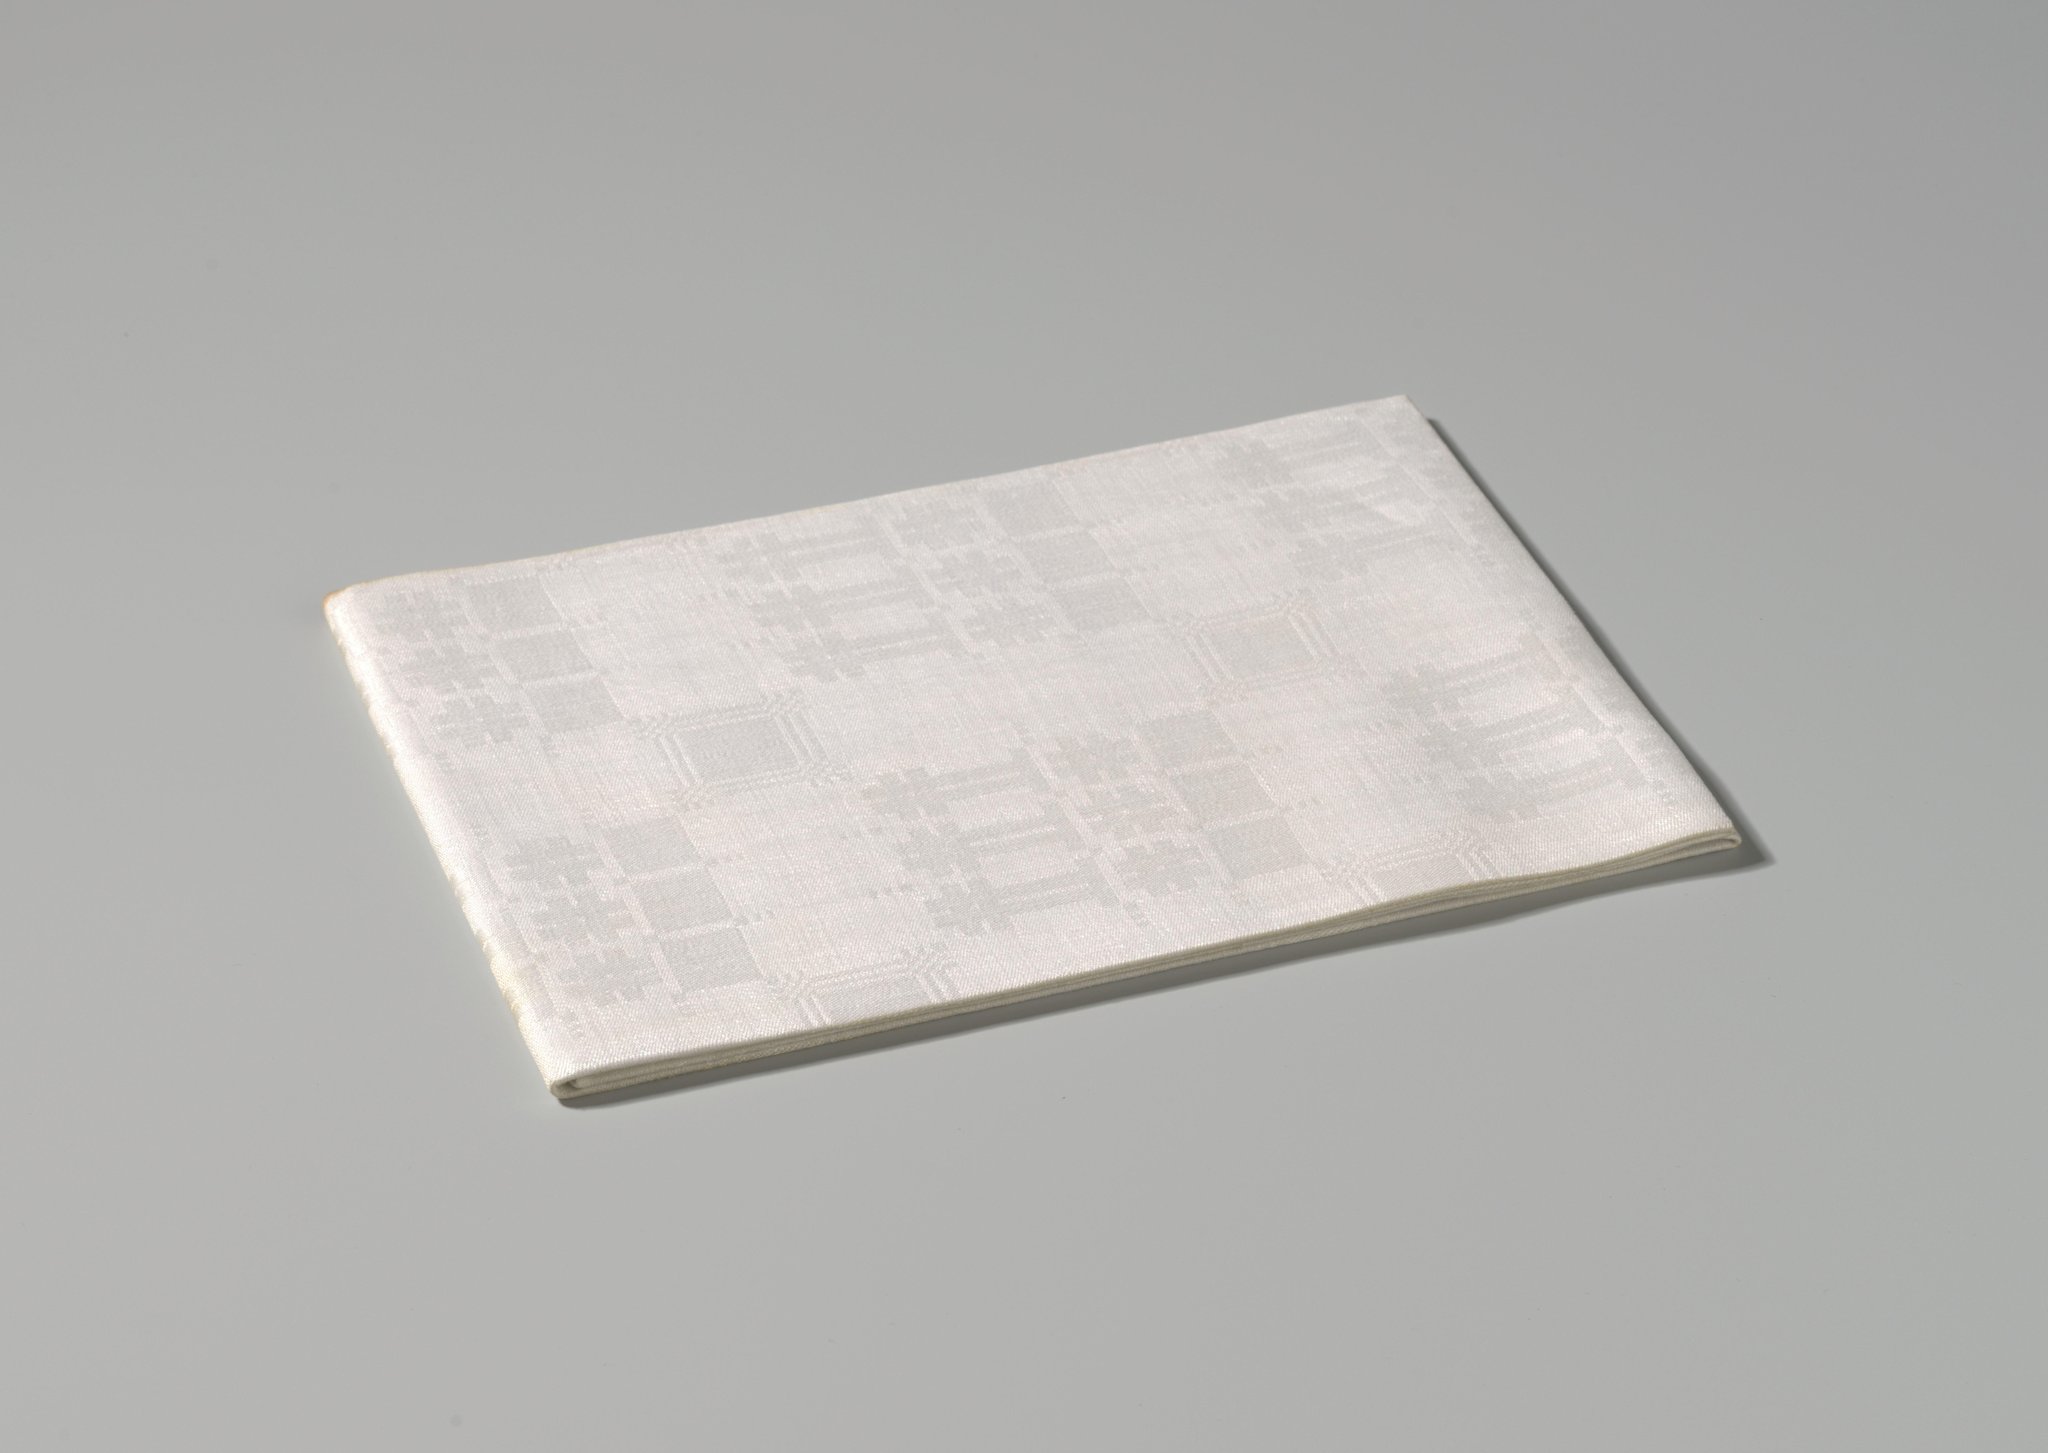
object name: napkin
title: Servet van linnen met pellenpatroon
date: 1725-1769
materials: linen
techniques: peeled fabric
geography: northern netherlands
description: wit linnen servet met pellen patroon, merk kroon ARVG 31